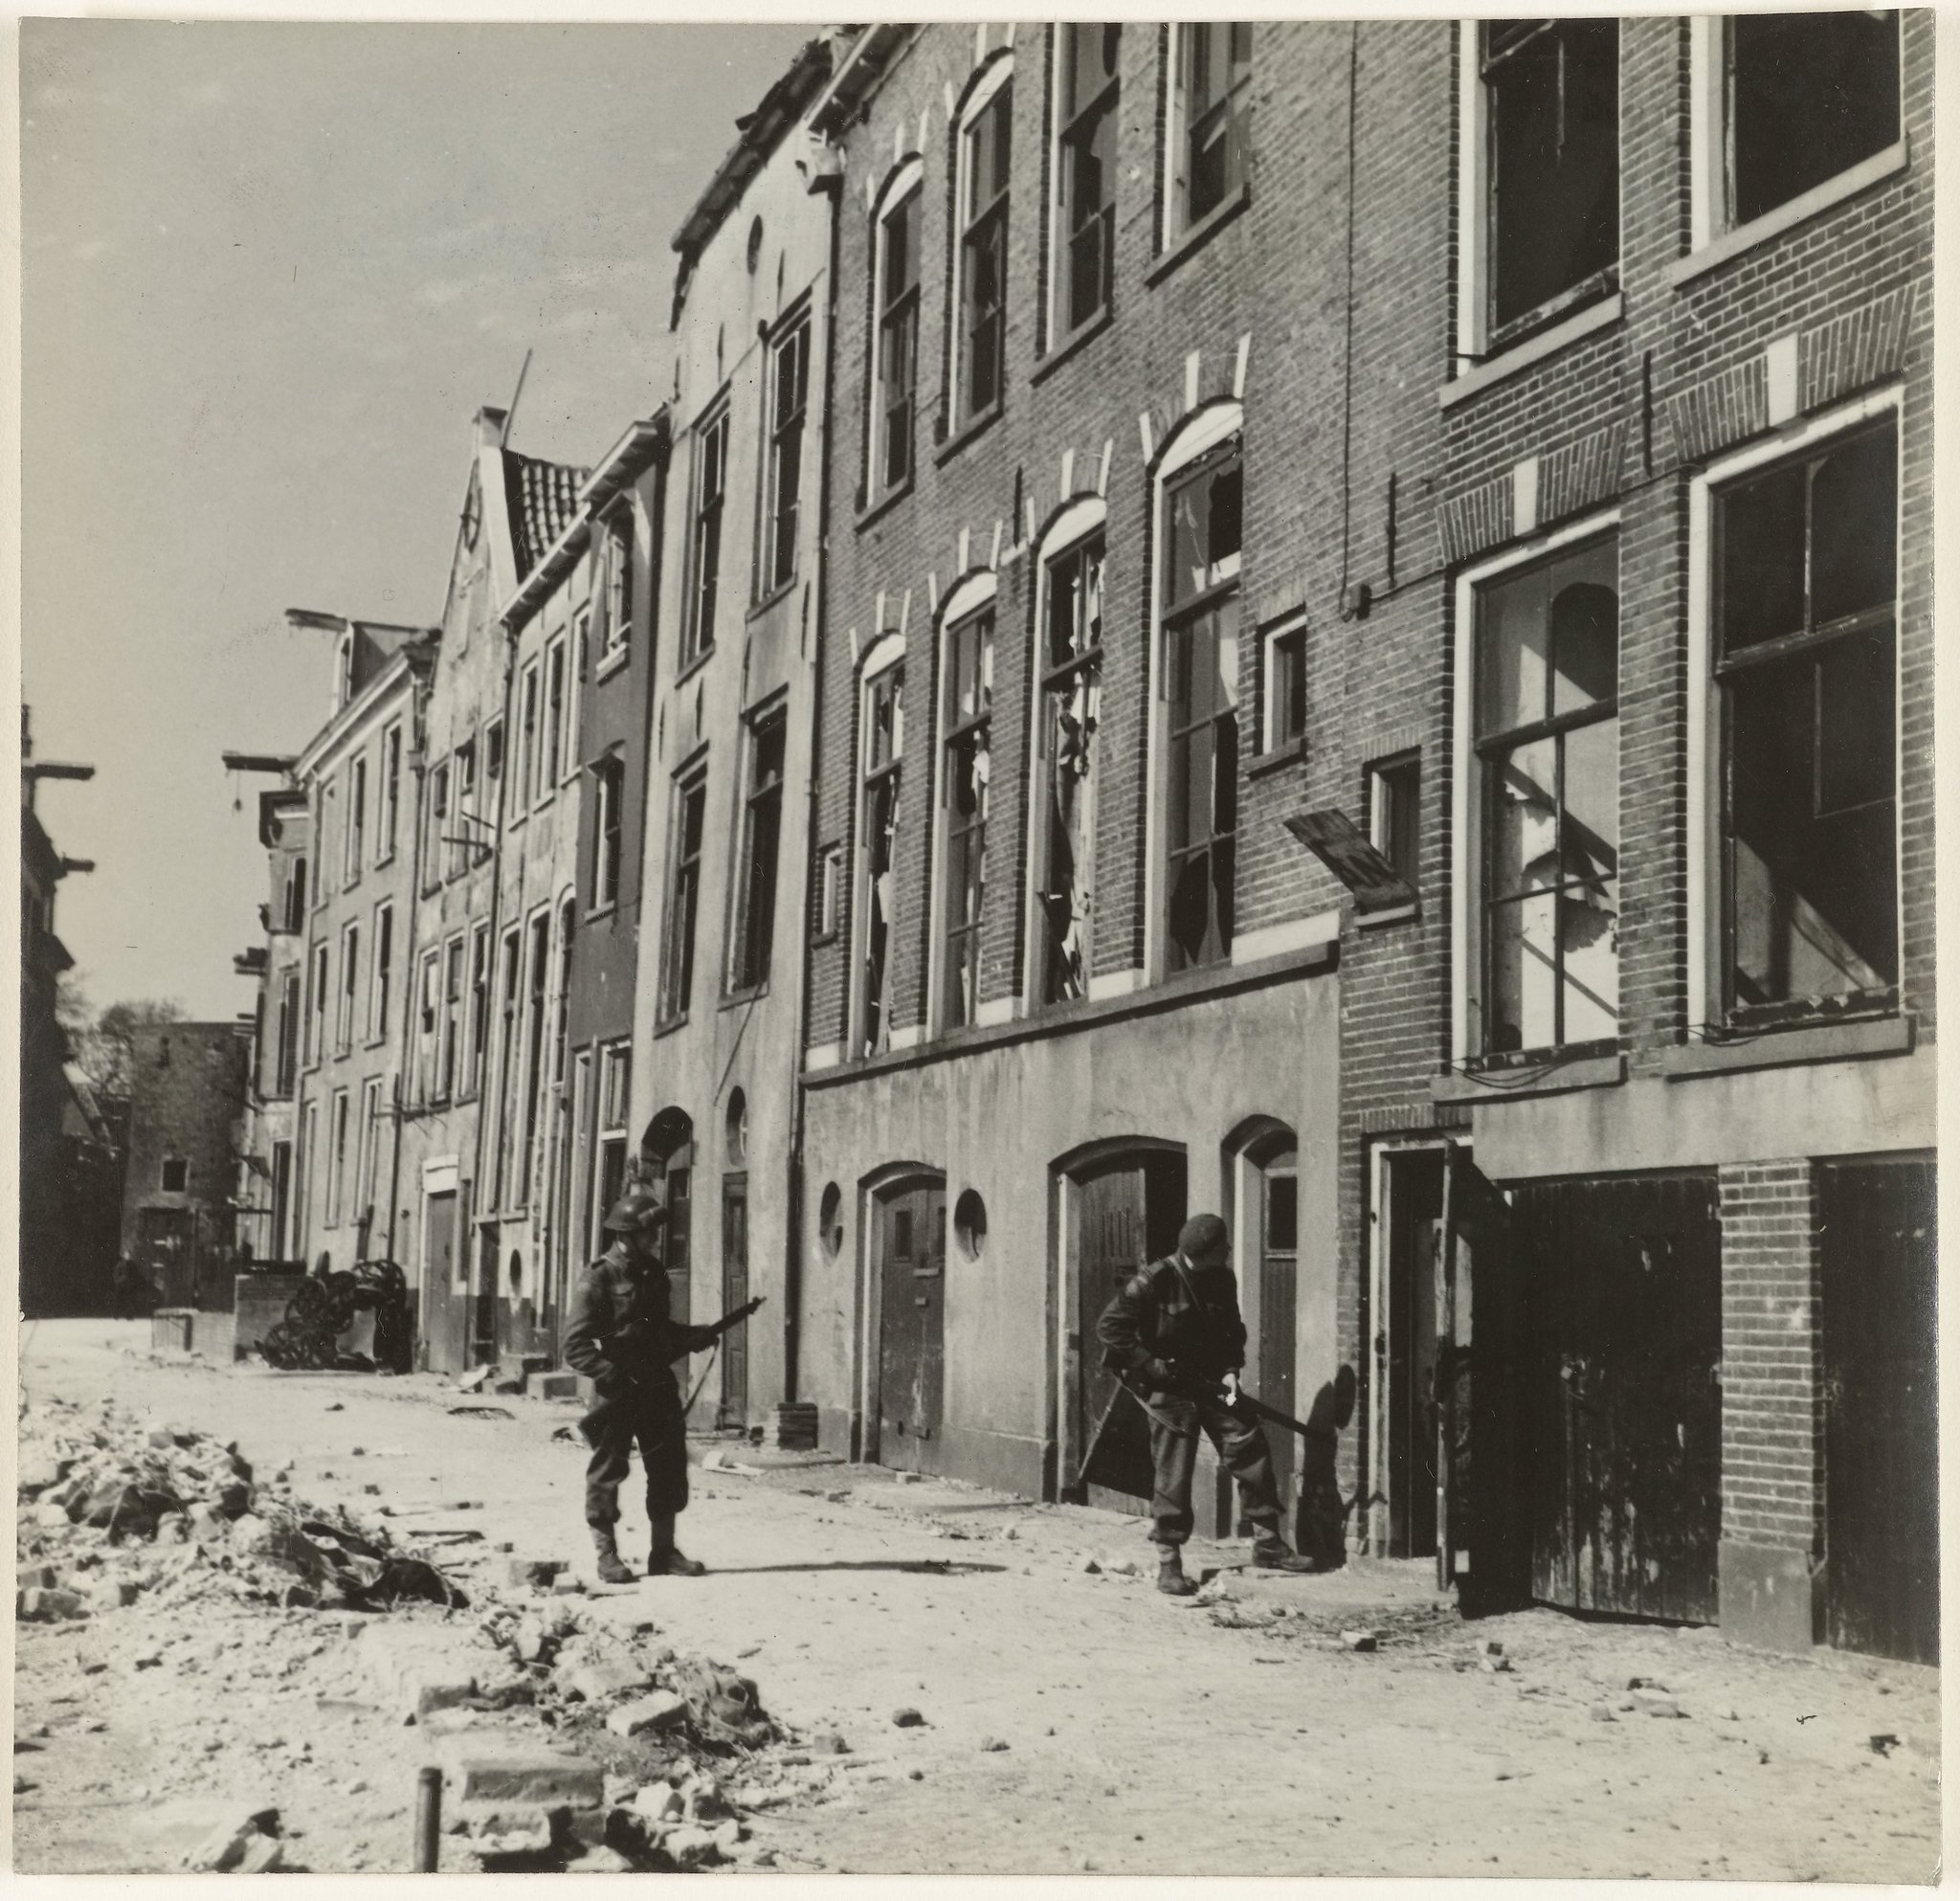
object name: photograph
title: Soldaten doorzoeken huizen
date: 1945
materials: photographic support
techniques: photography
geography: netherlands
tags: netherlands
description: Gezicht op een straat met verwoeste gebouwen. Soldaten van de geallieerden zijn bezig de huizen te doorzoeken.